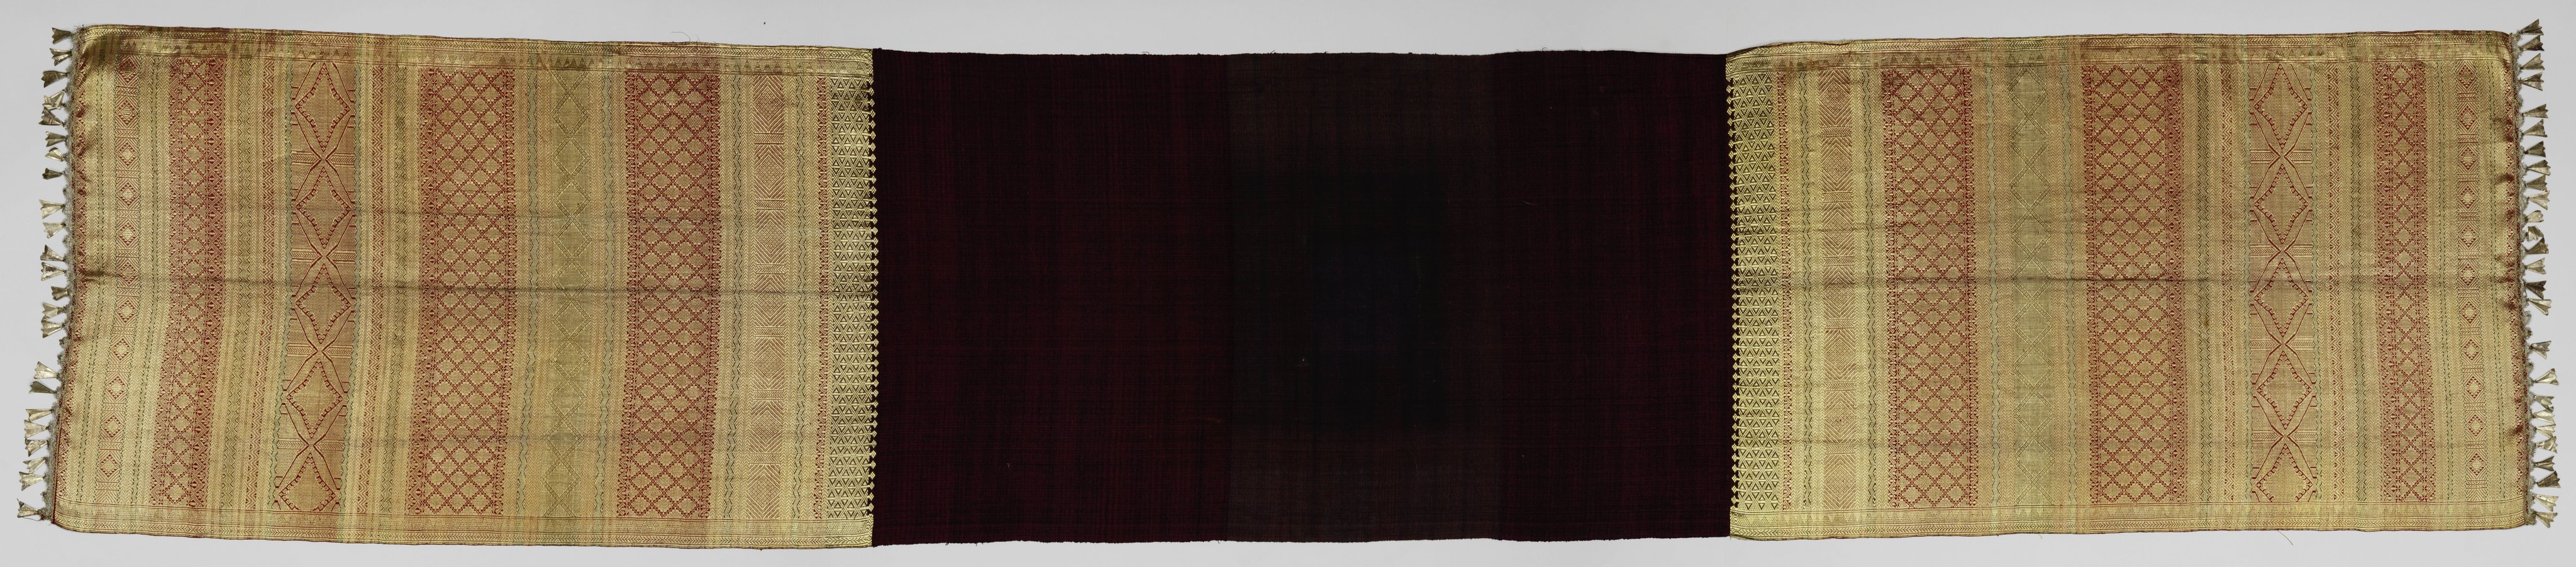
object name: head cloth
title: Tengkuluk; kain sandang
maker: Anonymous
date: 1995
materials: cotton, gold thread, metal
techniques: weave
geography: sumatera barat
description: Hoofddoek met geometrische motieven en stukjes blik aan franje.